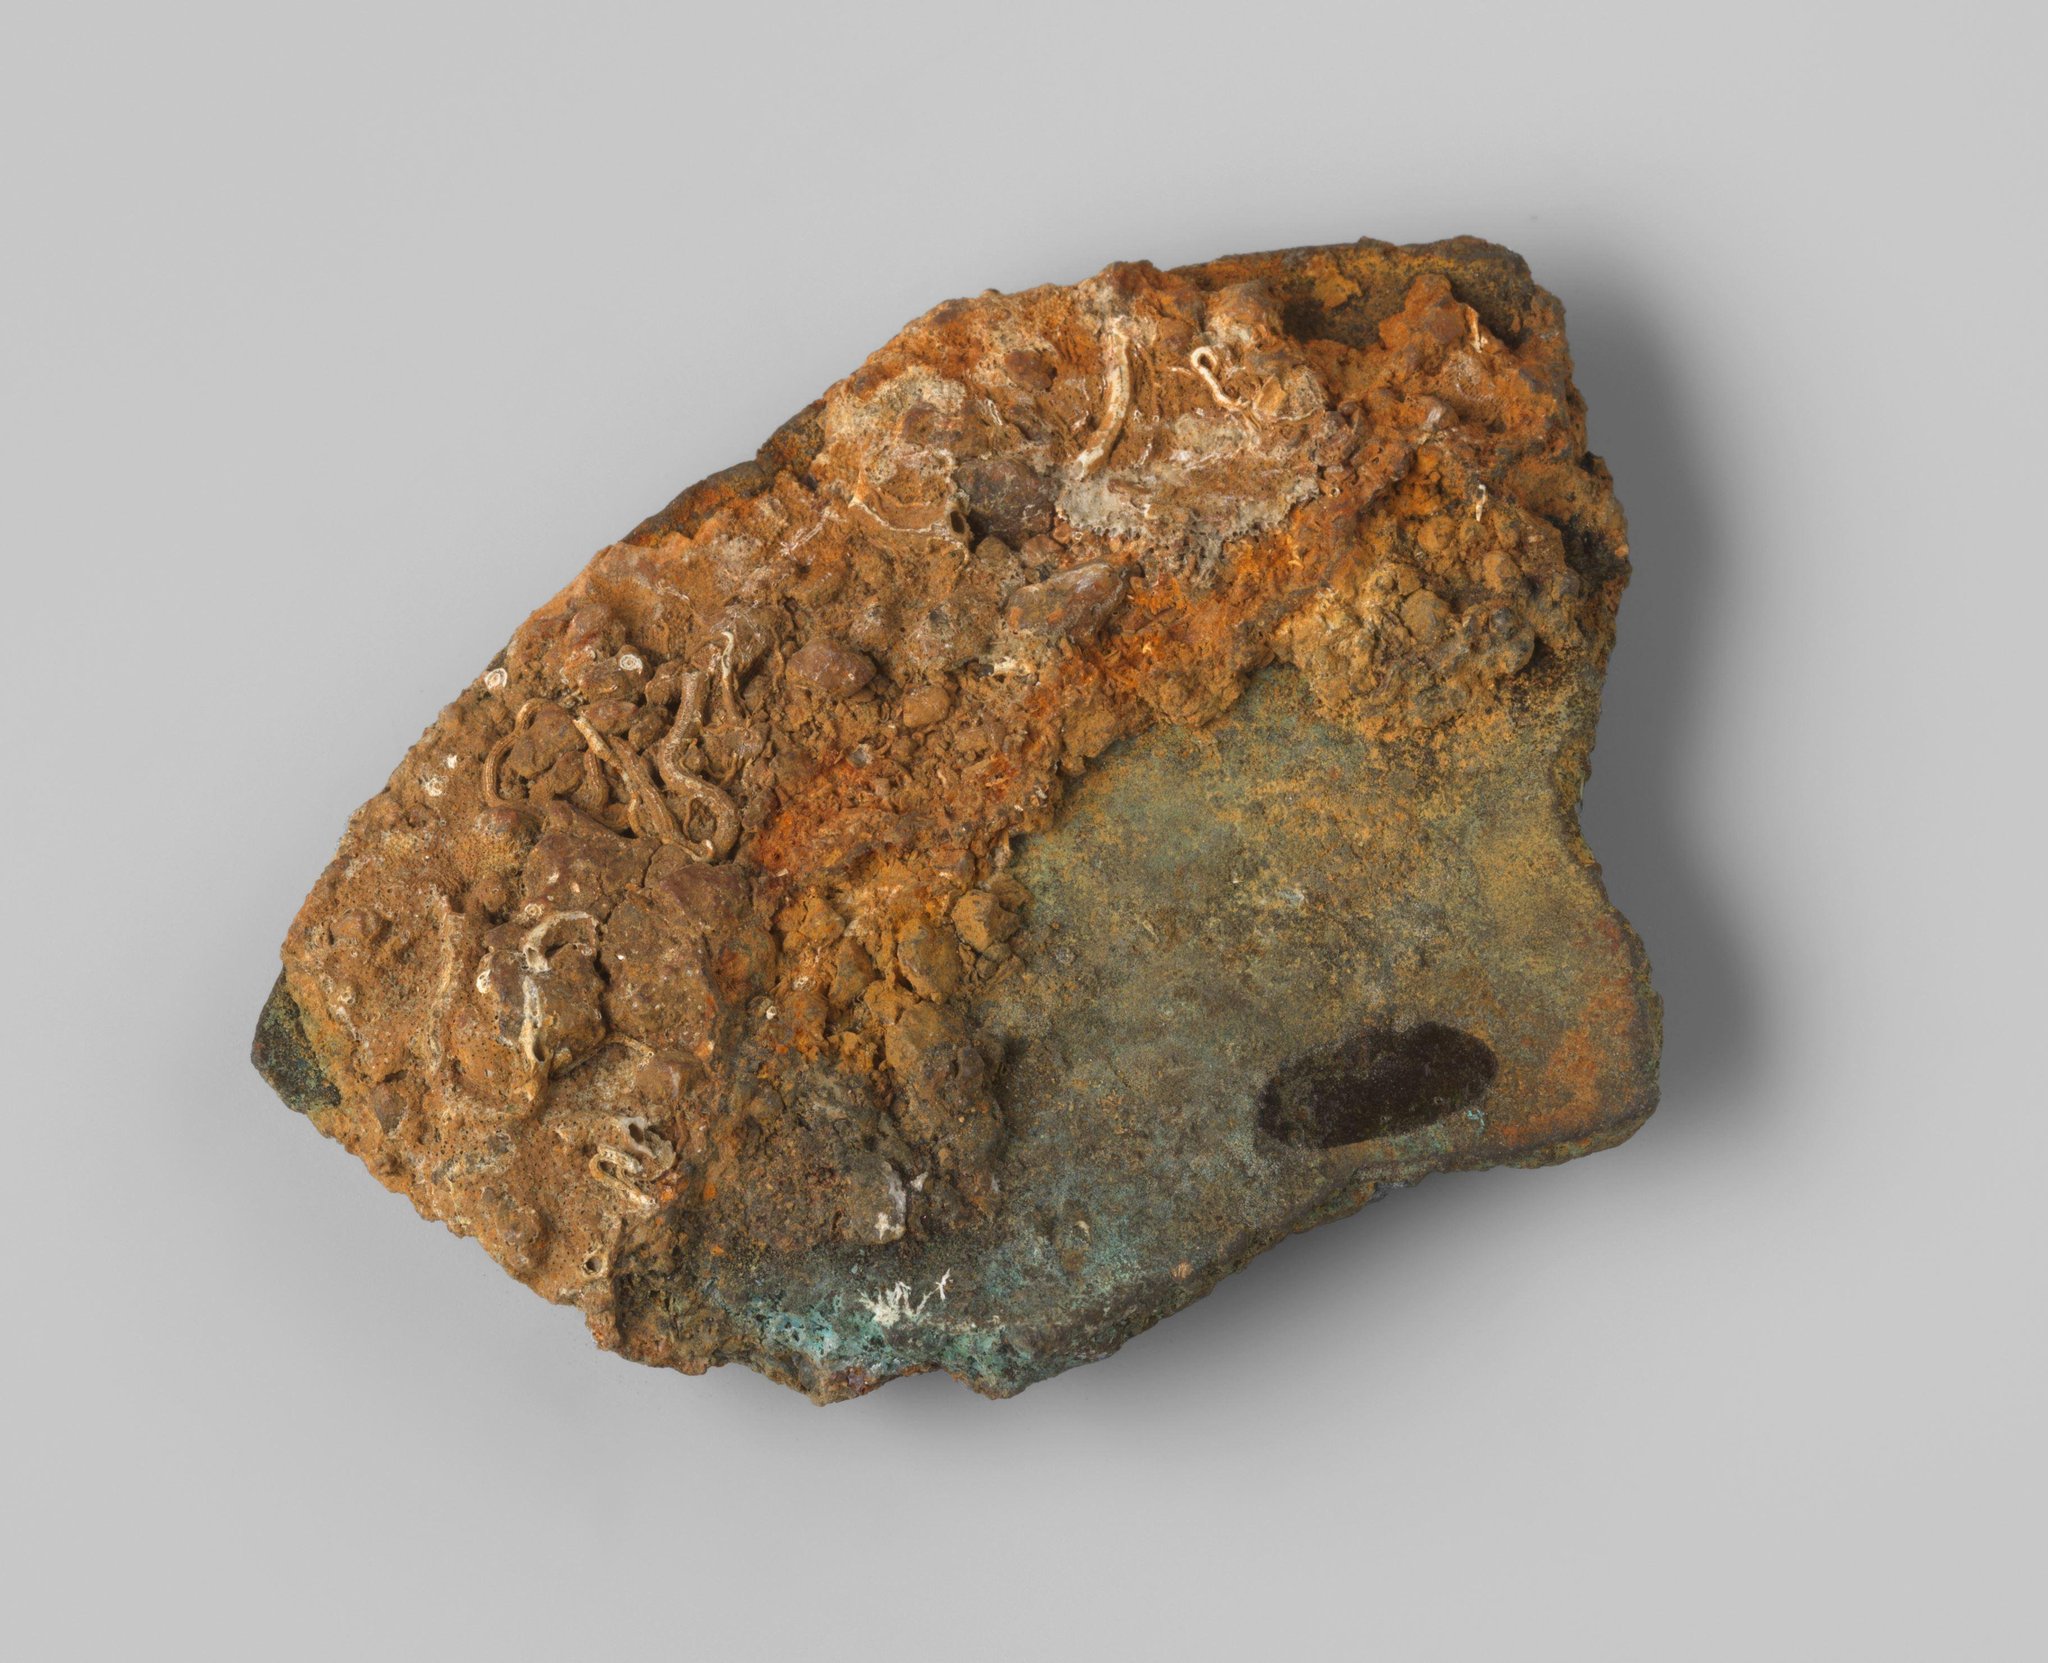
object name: bobeche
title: Fragment vetvanger uit het wrak van de Oost-Indiëvaarder Hollandia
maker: Anonymous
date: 1700-1743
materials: stone, copper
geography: netherlands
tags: verenigde oostindische compagnie, hollandia (schip), annet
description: Candlestick, drip-pan; fragm of rim, id. NG 1980-27H867.